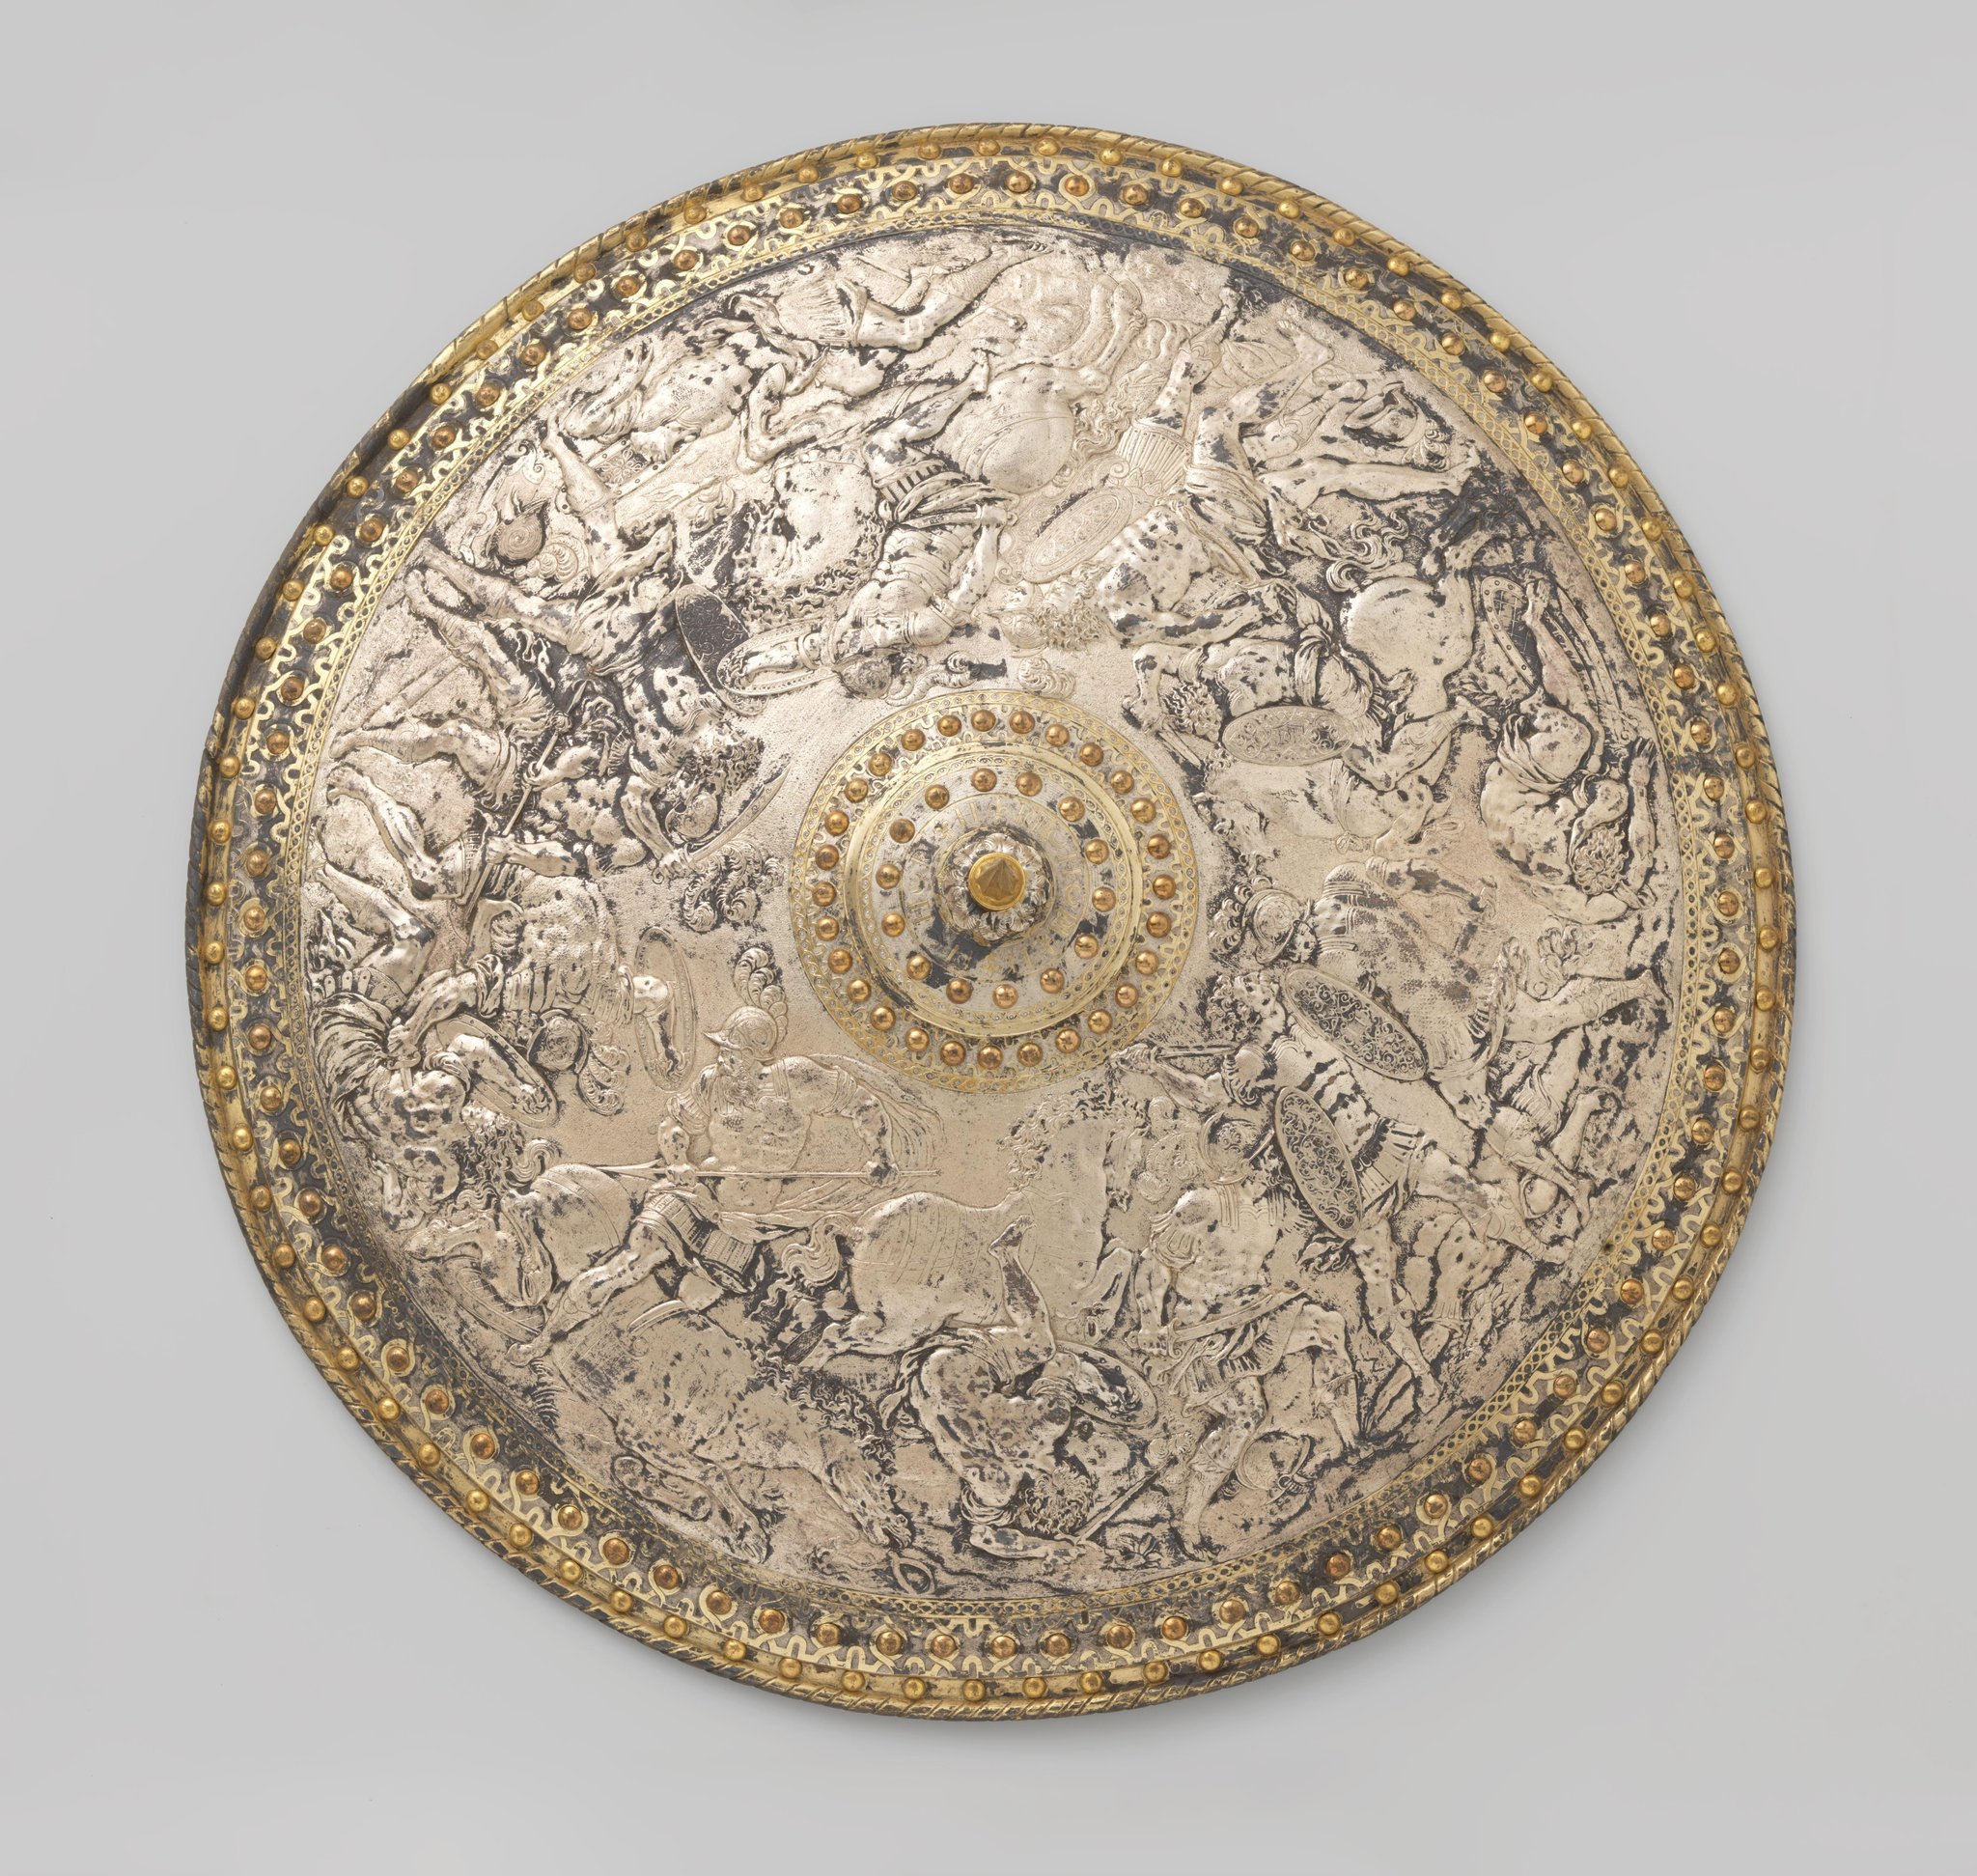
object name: shield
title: Galvanoplastische reproductie van een schild met een Romeinse strijdscène en twee monogrammen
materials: copper, silver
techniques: gilding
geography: london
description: Galvanoplastische reproductie van een schild, rondas, met een gedreven voorstelling van een Romeinse strijdscène en de monogrammen en helmtekens van Henri II van Frankrijk en Diana van Poictiers. Gedeeltelijk verguld.